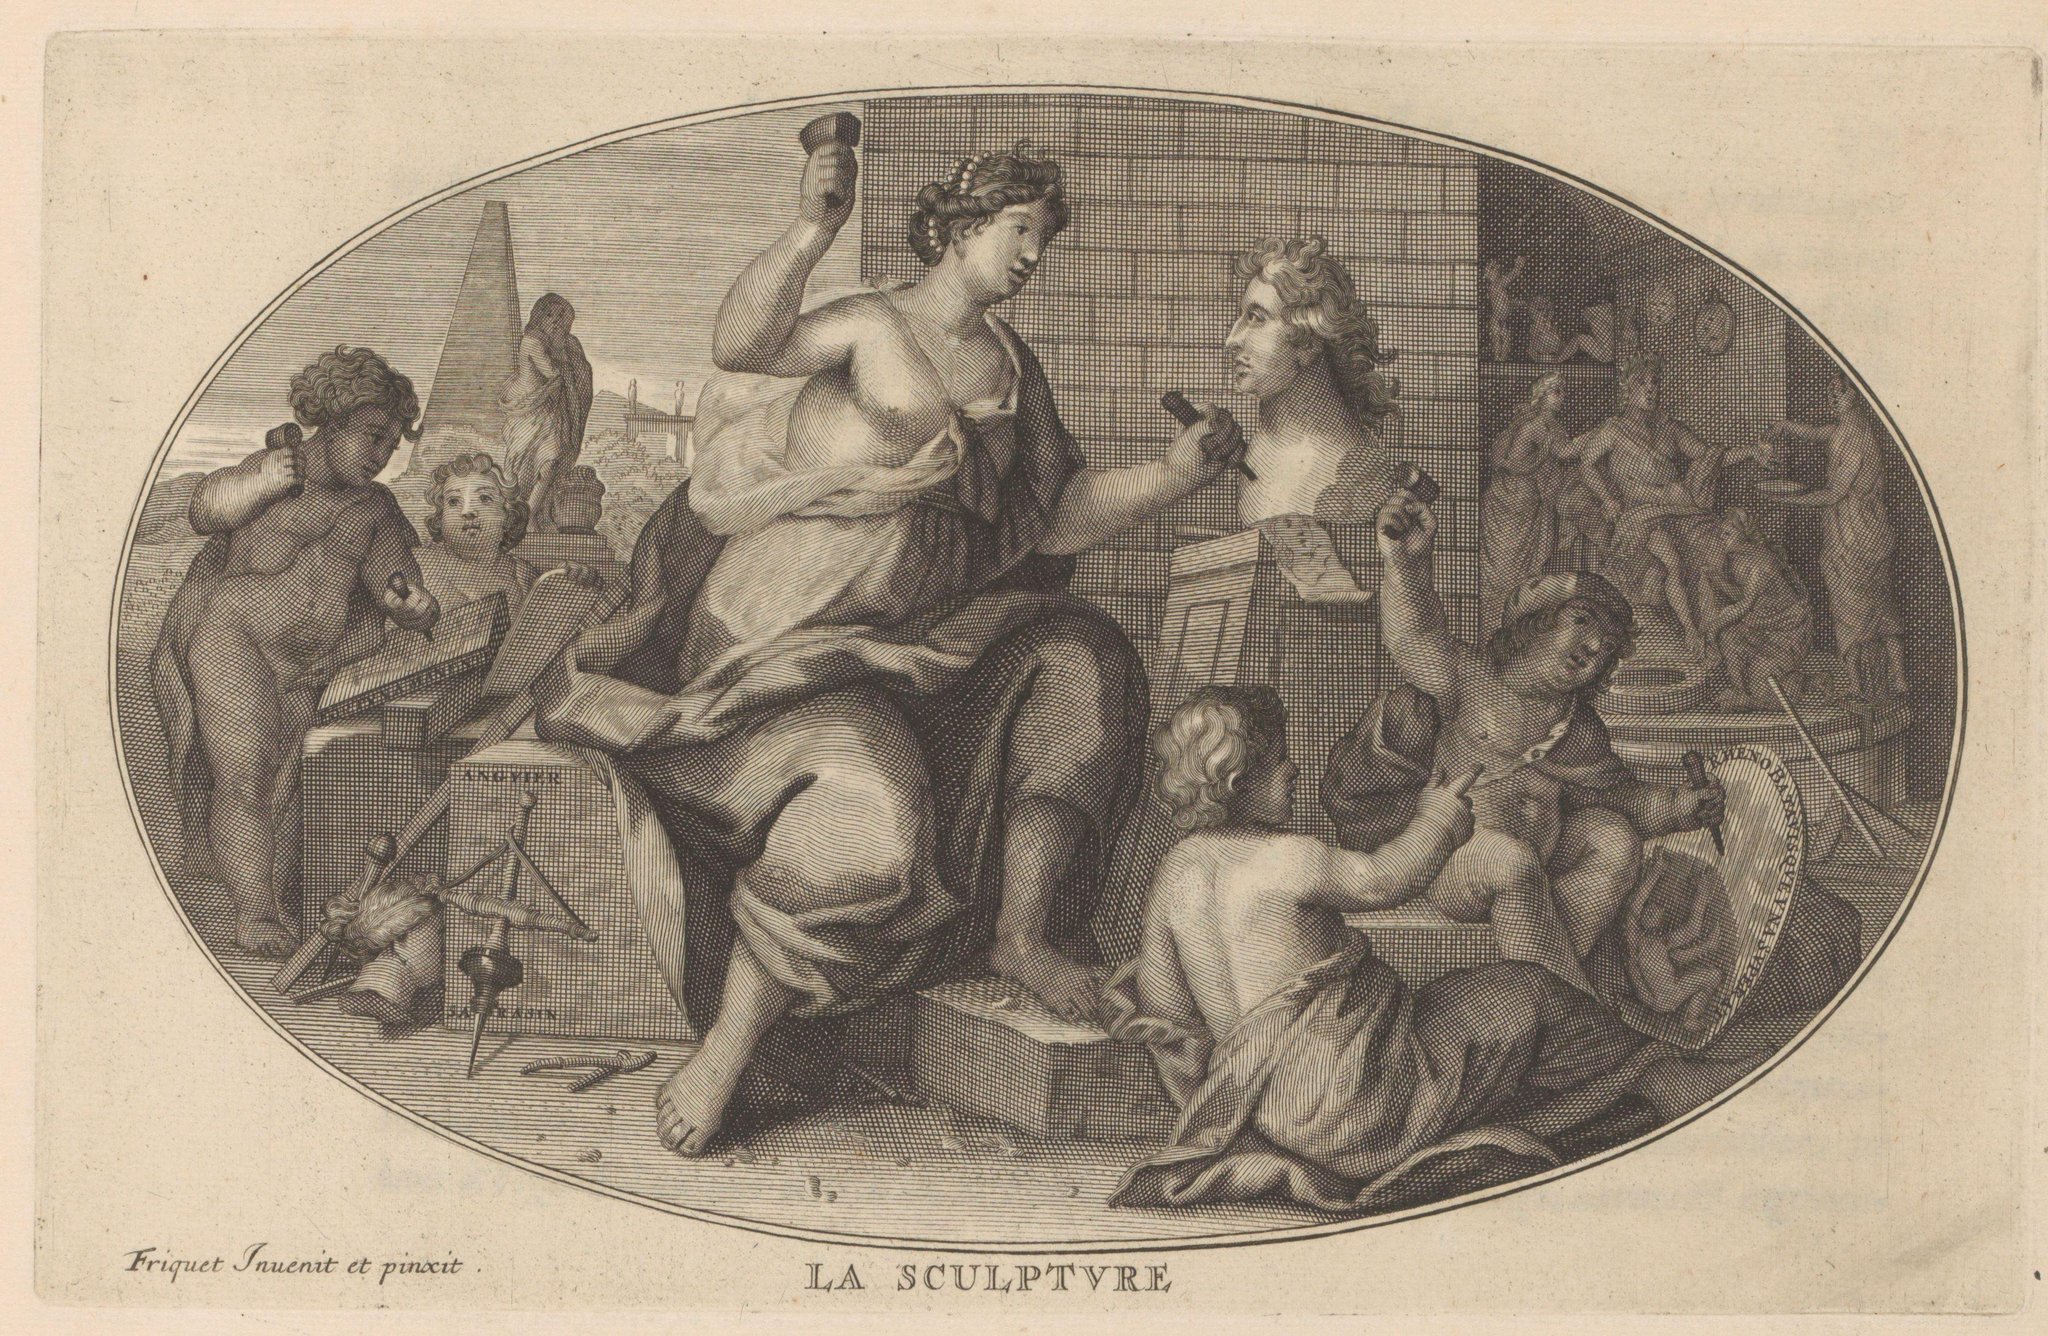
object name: print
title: Beeldhouwkunst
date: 1695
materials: paper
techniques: engraving, etching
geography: paris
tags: 'sculptura', symbolic representations, allegories and emblems ~ sculpture; 'scoltura' (ripa), (decorated) ceiling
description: Plafondstuk met de personificatie van Beeldhouwkunst of Sculptuur. Zij beeldhouwt een borstbeeld van Lodewijk XIV. Putti assisteren haar. Prent maakt deel uit van een album.